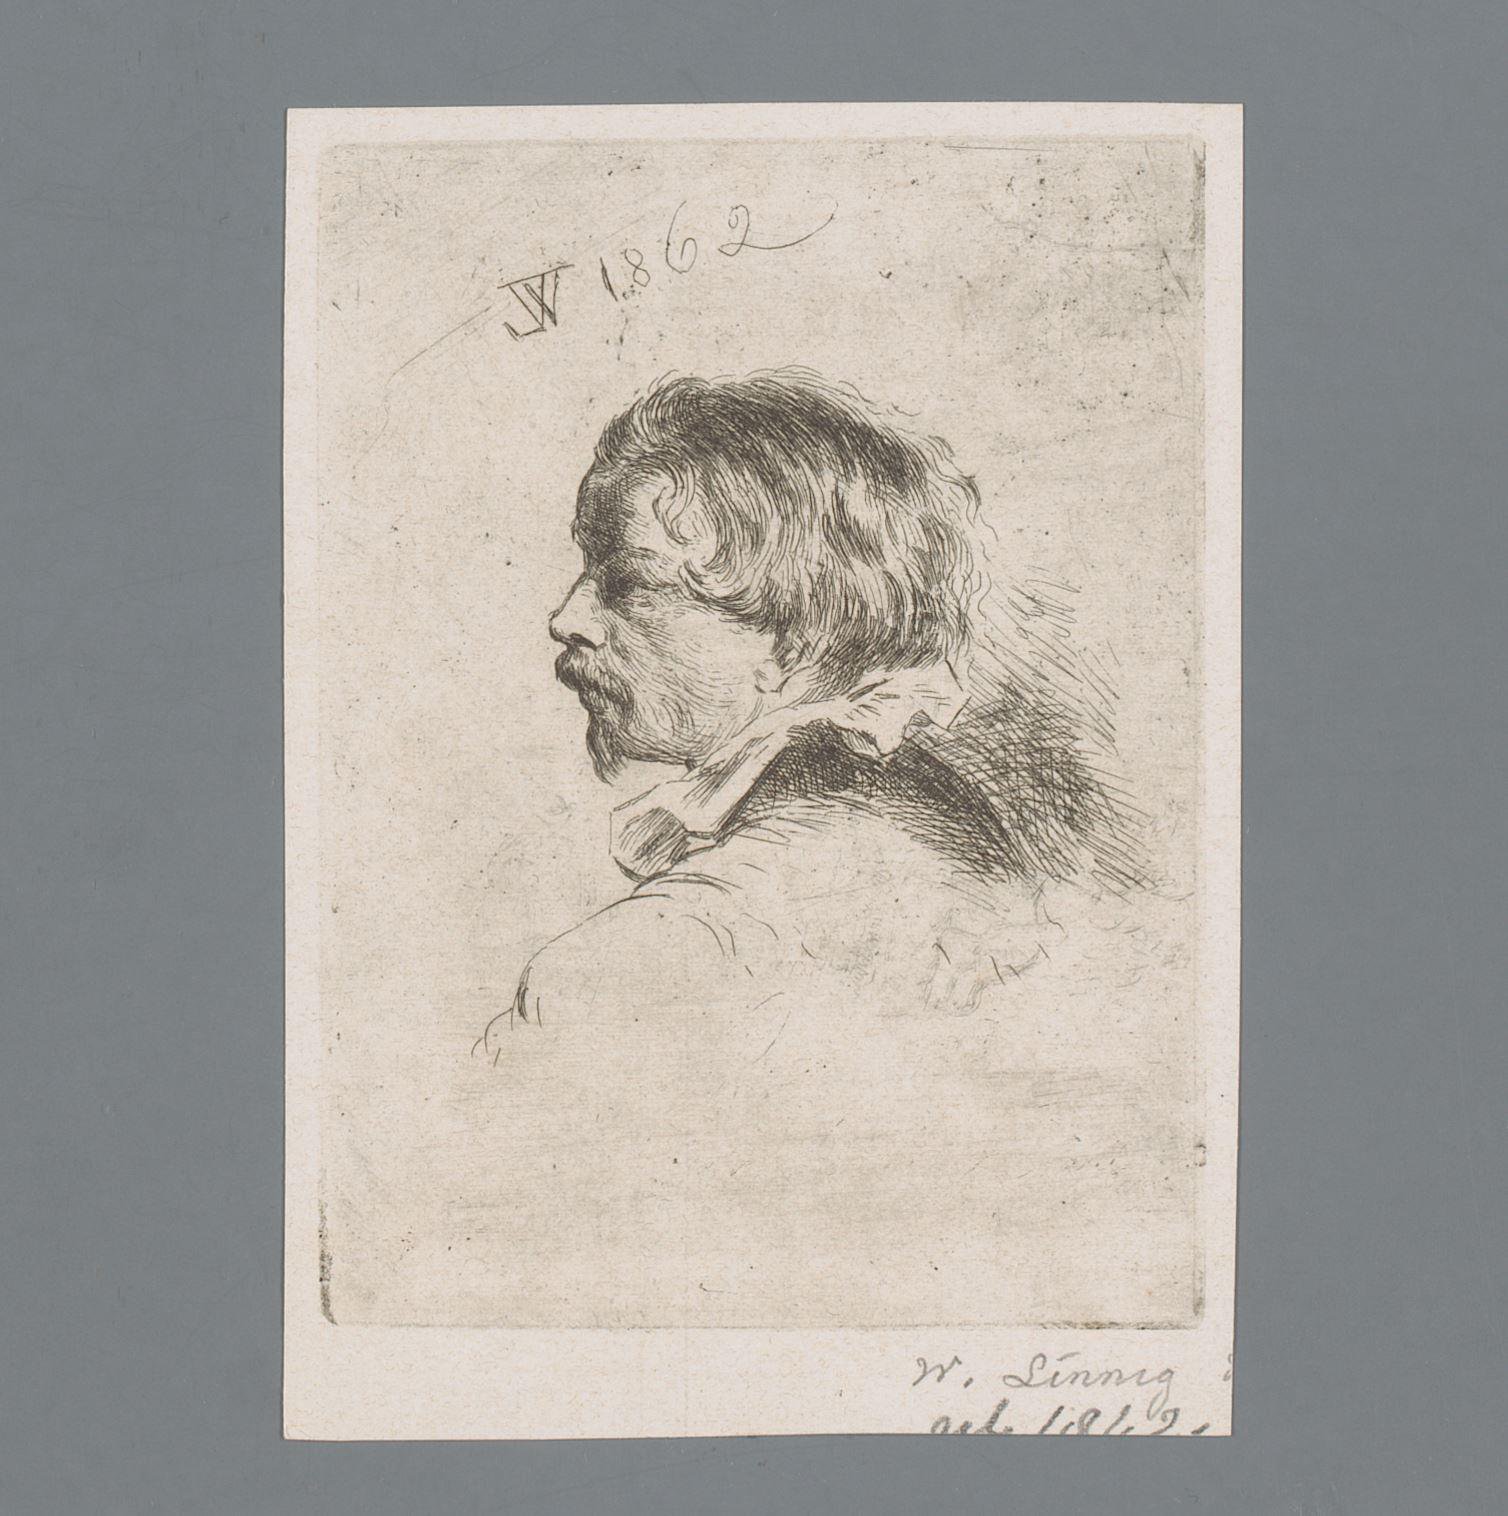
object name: print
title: Portret van een onbekende man, mogelijk Victor Antonius Praet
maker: willem linnig (ii)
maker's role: print maker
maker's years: 1842-1890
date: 1862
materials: paper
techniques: etching, intaglio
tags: historical persons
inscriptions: collector's mark: Lugt 2228